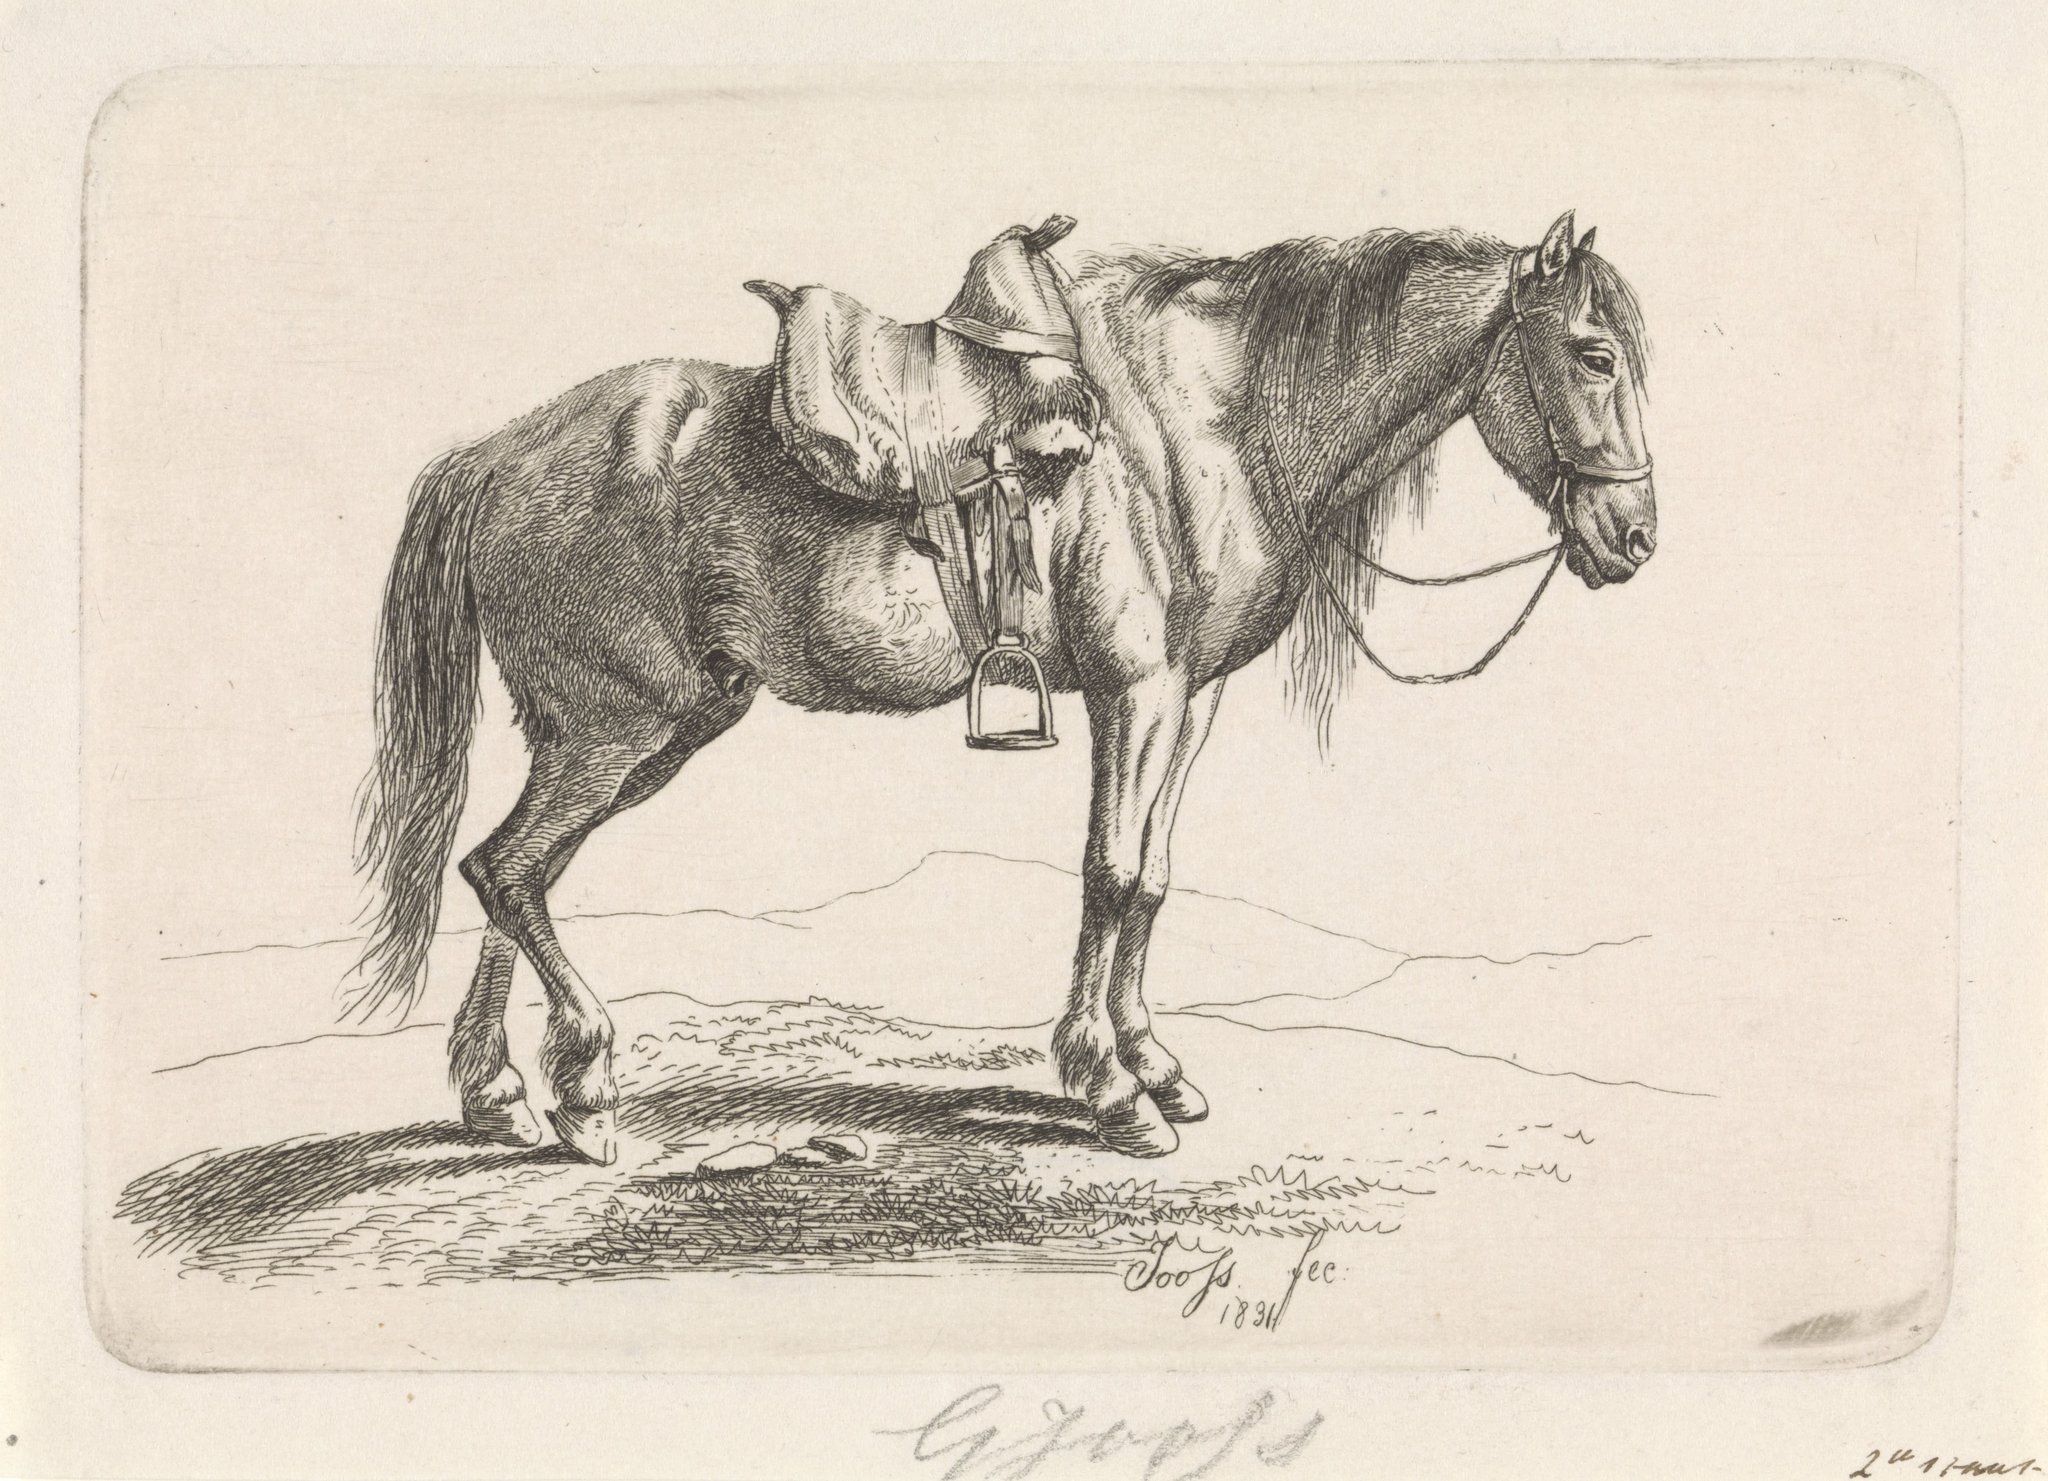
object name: print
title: Gezadeld paard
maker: george jooss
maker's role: print maker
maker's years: 1799-1845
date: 1831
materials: paper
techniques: etching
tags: horses and kindred animals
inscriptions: collector's mark: Lugt 2228, inscription: ‘2u staat’